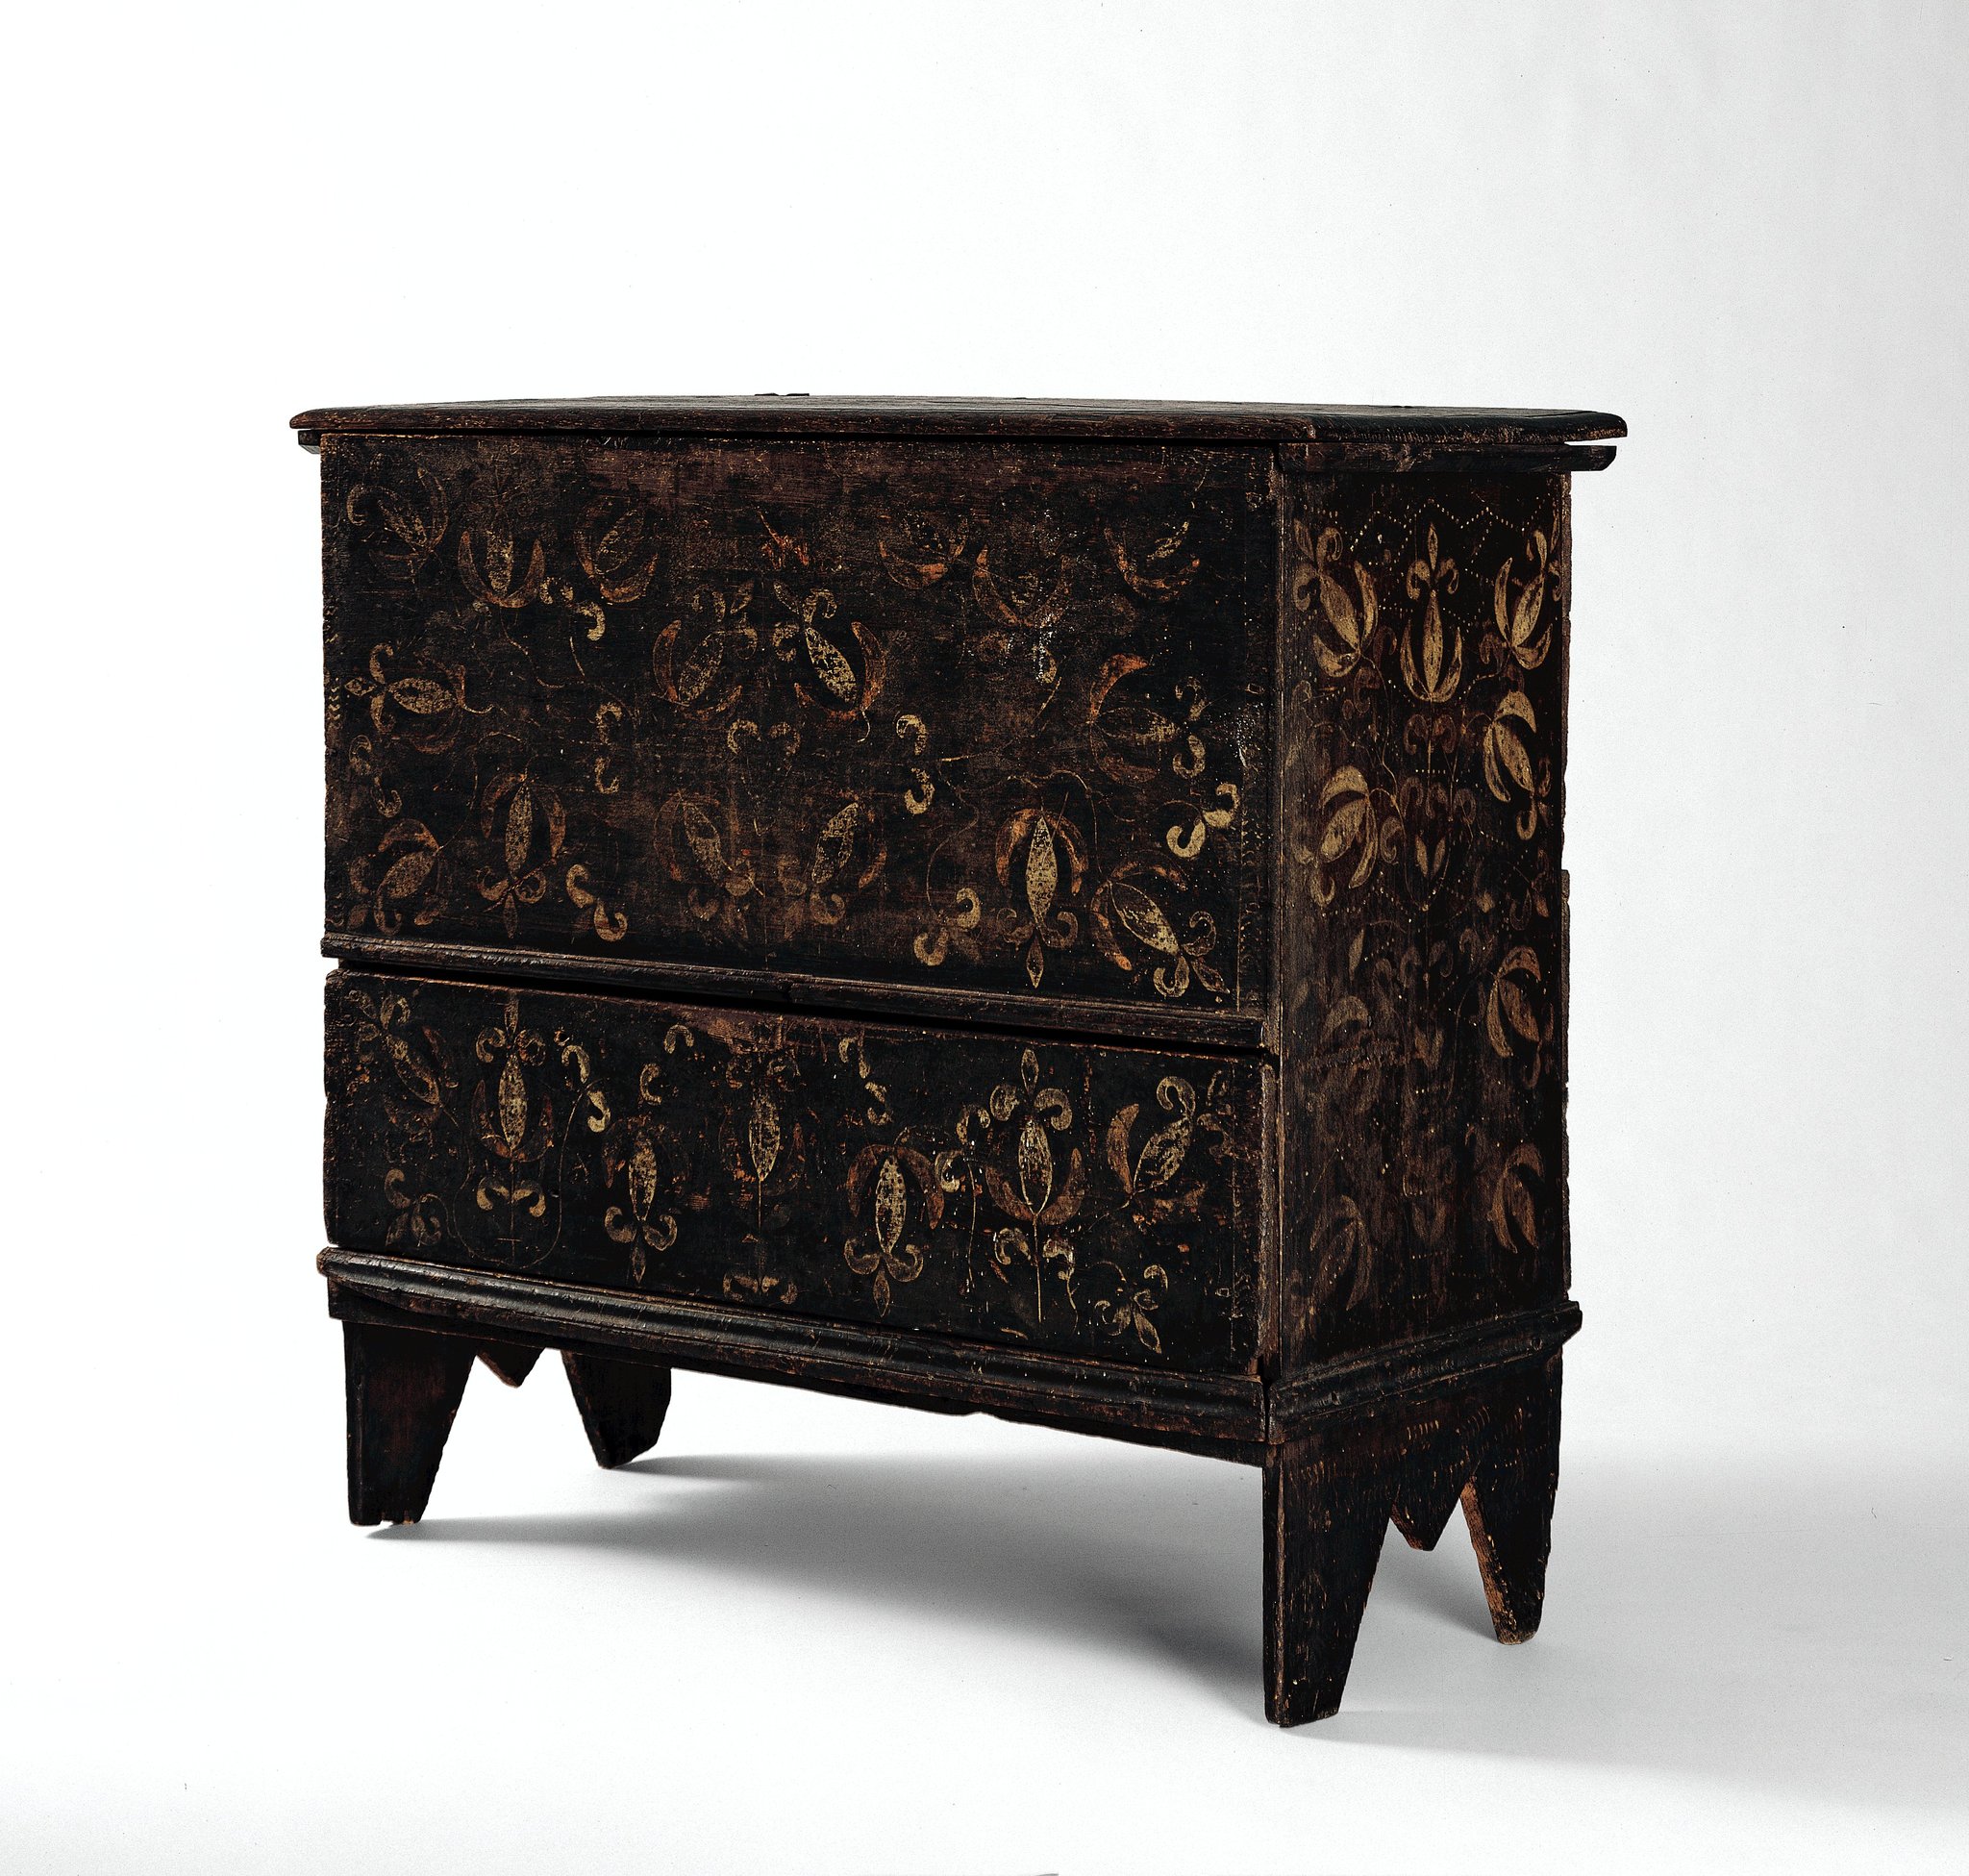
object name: chest of drawer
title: Chest-with-drawer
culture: american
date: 1700-1730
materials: wood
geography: united states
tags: flowers